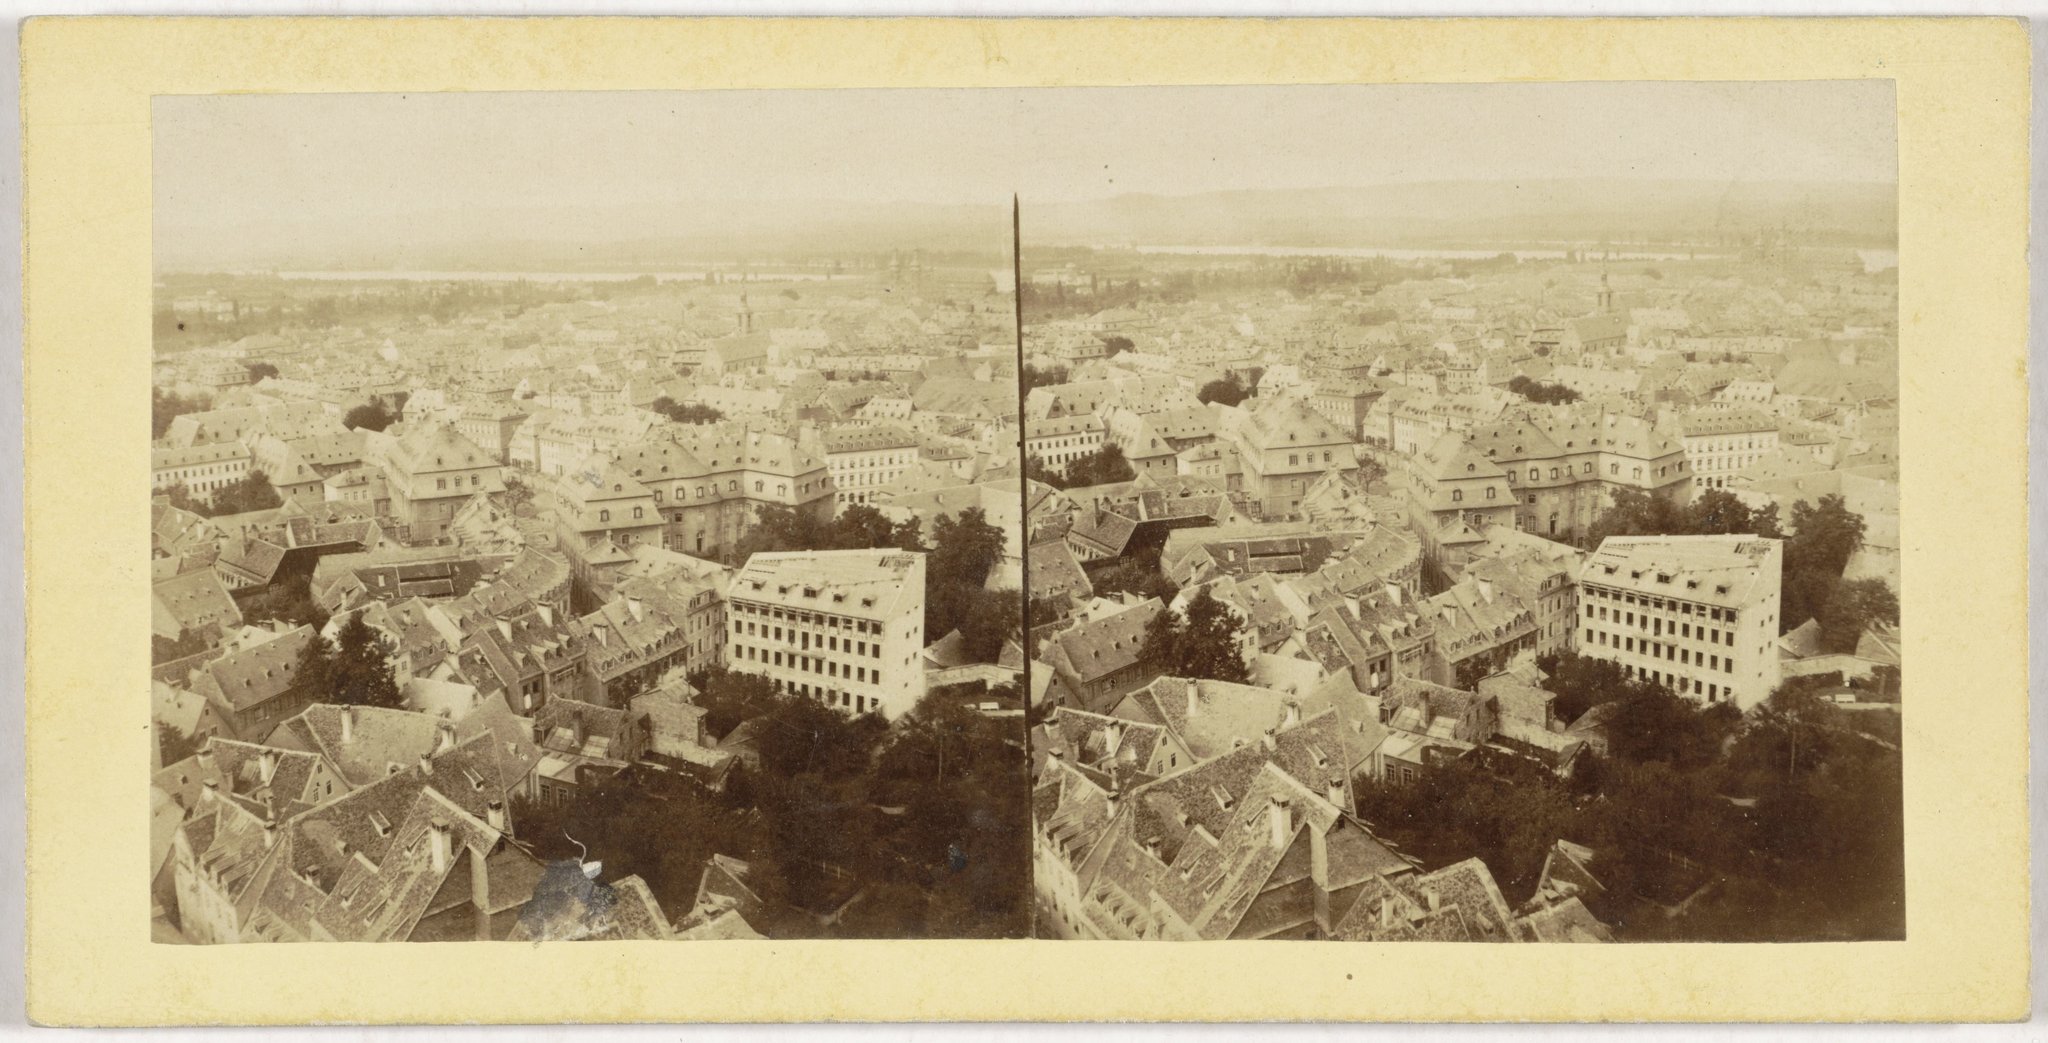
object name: stereograph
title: Gezicht op Mainz, Duitsland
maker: Anonymous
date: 1861-1870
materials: cardboard, paper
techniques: albumen print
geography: mainz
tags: city-view in general; 'veduta'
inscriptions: inscription: ‘M/ L’, number: ‘No 62’